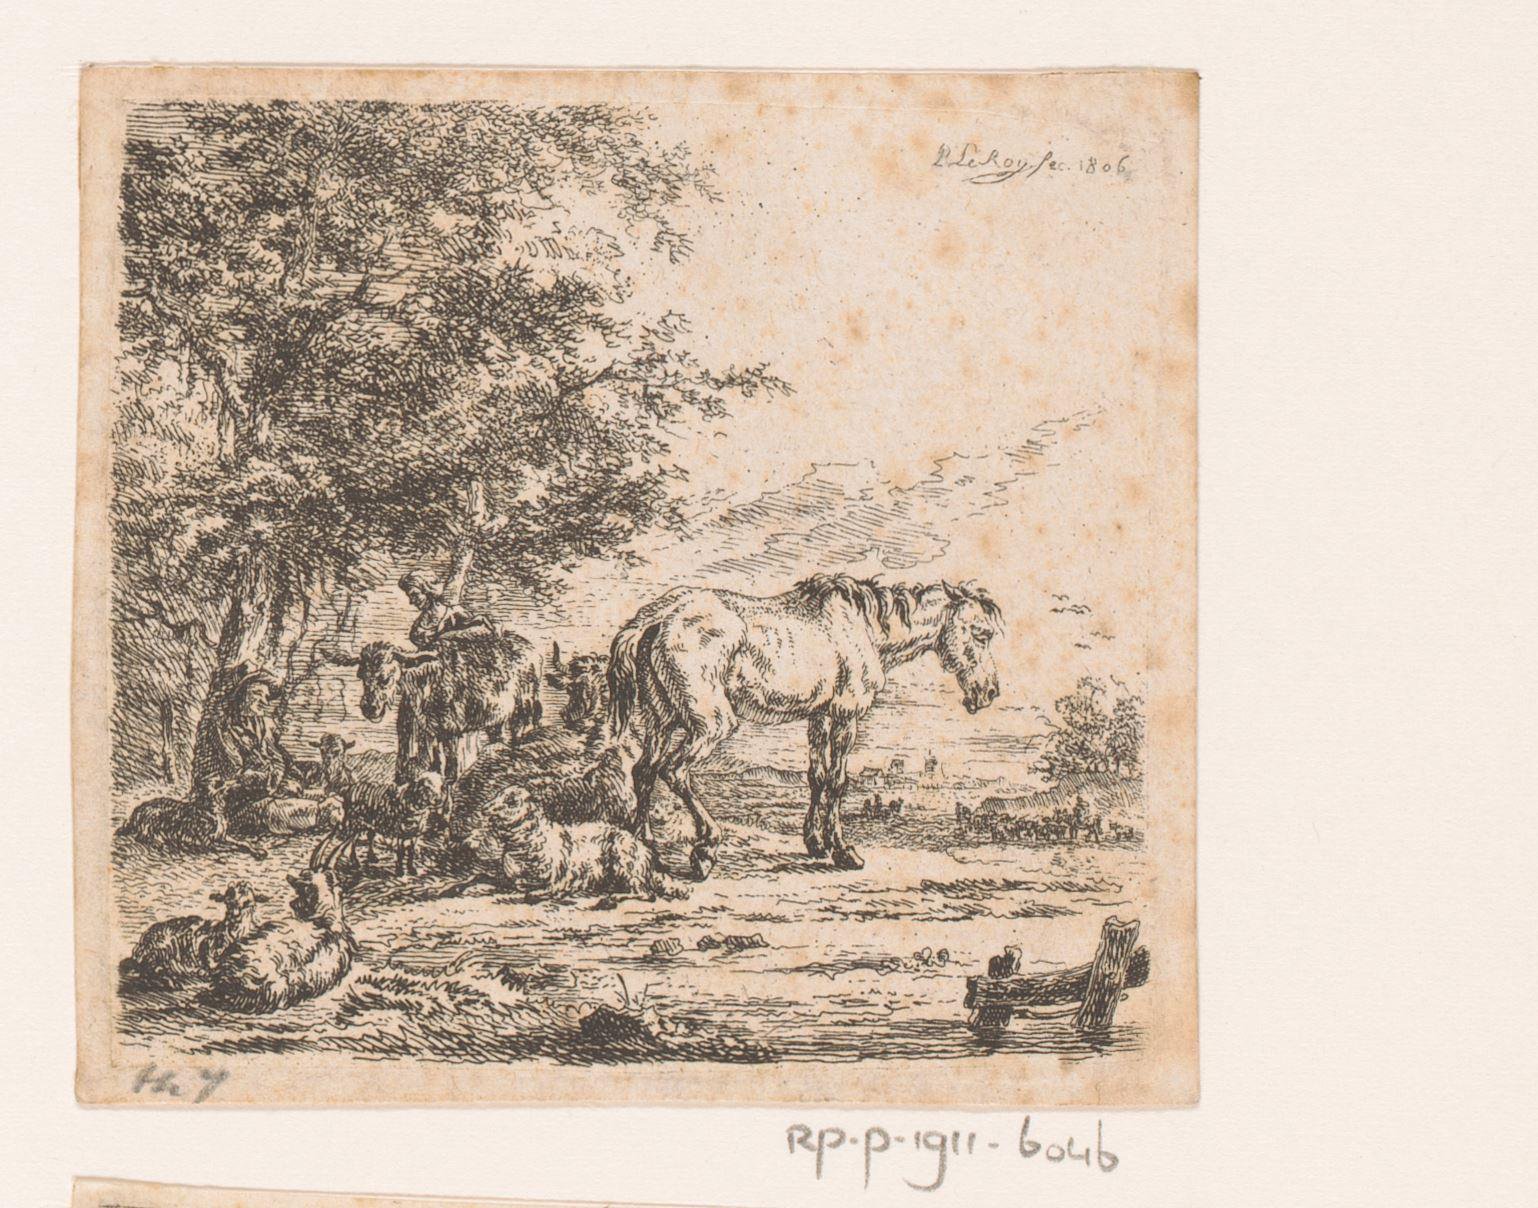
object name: print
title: Herder en herderin met hun dieren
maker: pierre-françois le roy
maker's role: draughtsman, painter, print maker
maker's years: 1771-1862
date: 1806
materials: paper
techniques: etching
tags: herding, herdsman, herdswoman, shepherd, shepherdess, cowherd, etc.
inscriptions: collector's mark: Lugt 1485, collector's mark: Lugt 2228